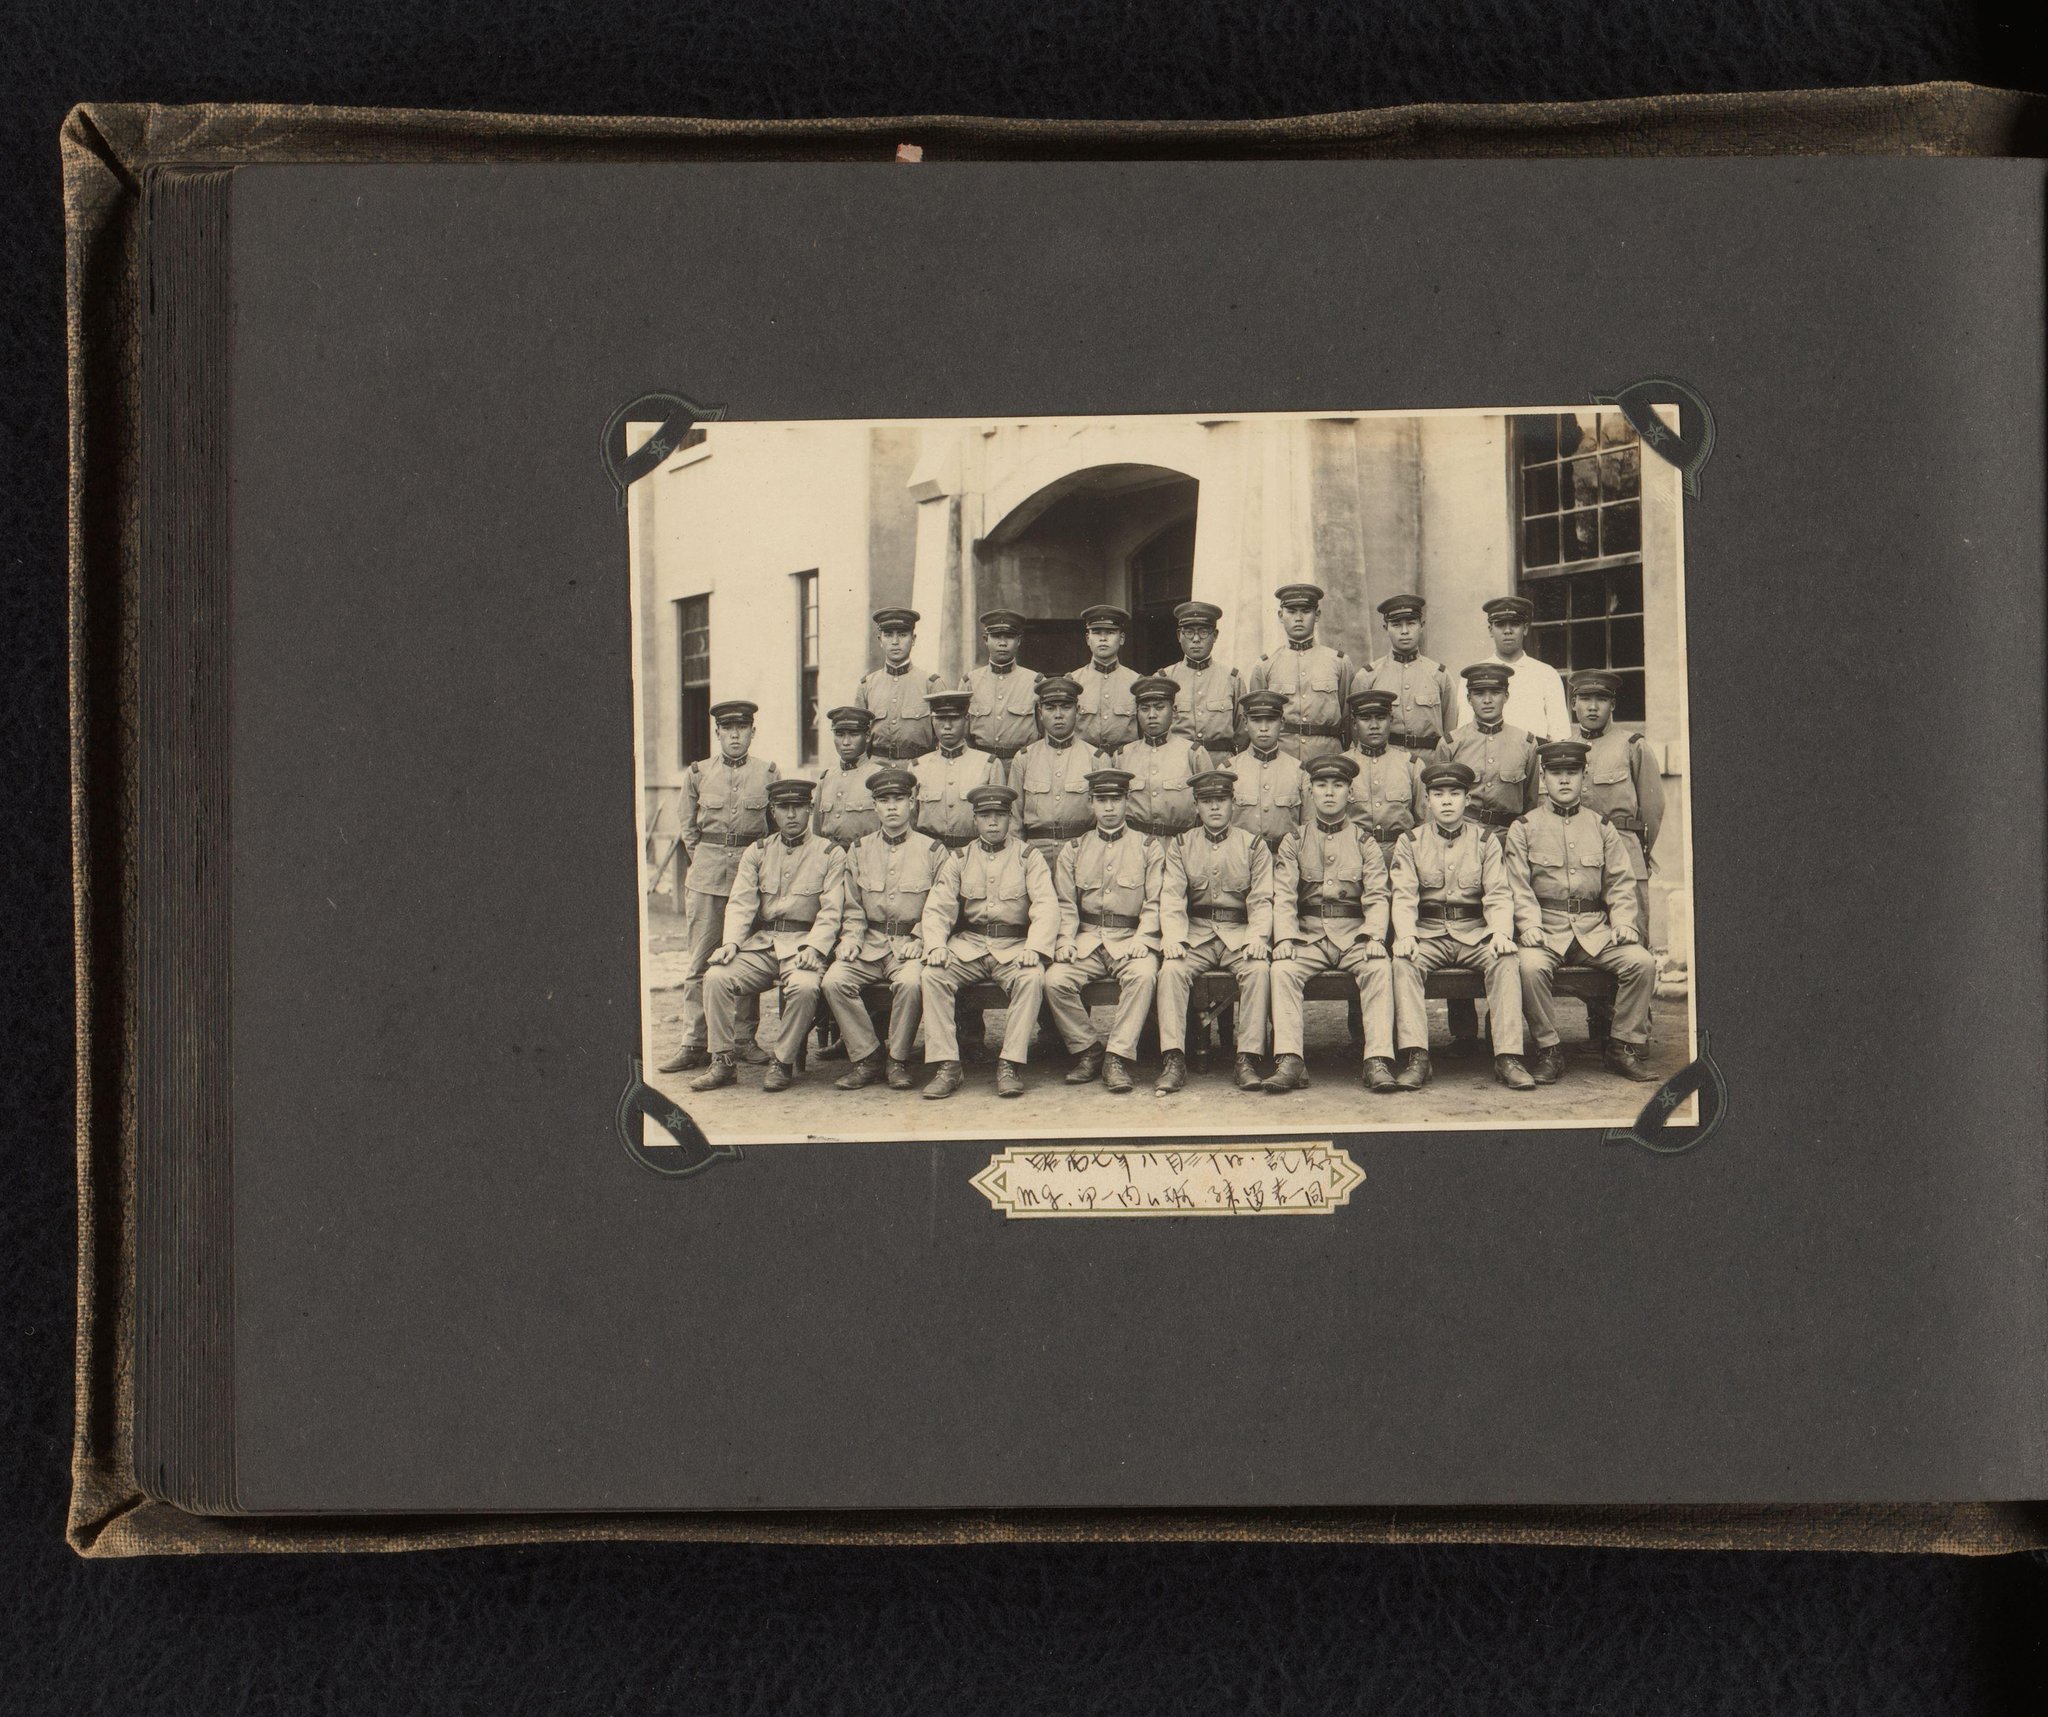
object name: photograph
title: Groepsportret van onbekende Japanse soldaten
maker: Anonymous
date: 1930-1940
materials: paper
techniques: gelatin silver print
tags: the soldier; the soldier's life, anonymous historical persons portrayed in a group, in a group-portrait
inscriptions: inscription: ‘[...]’